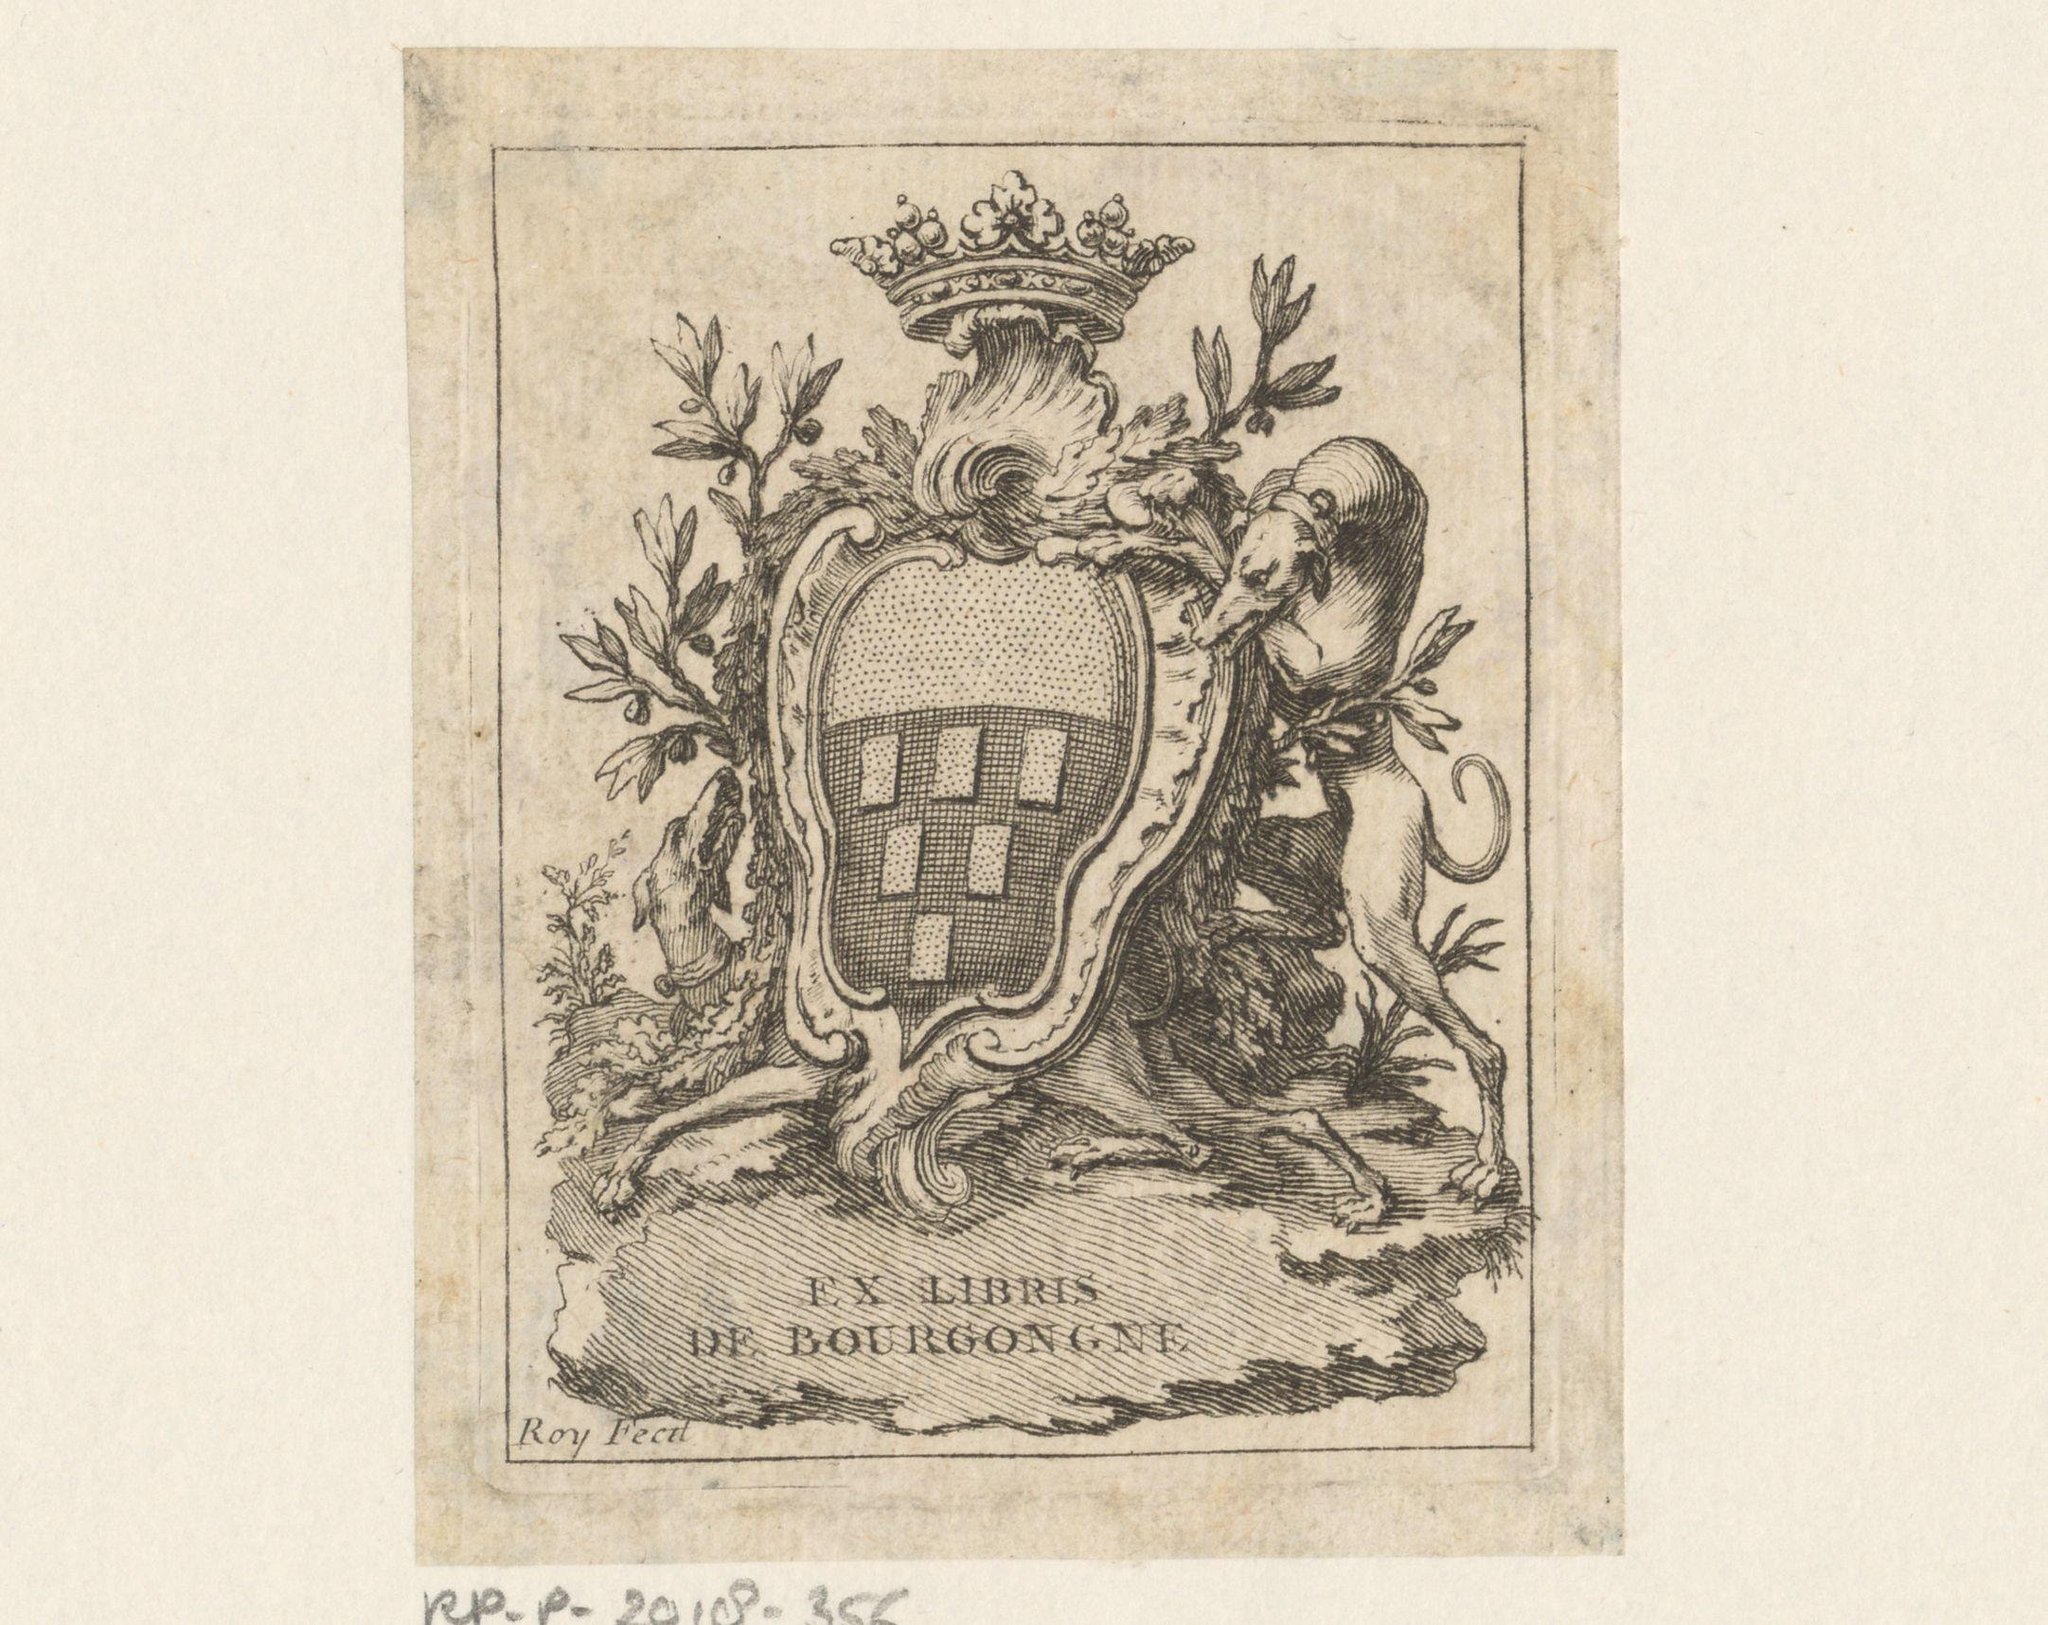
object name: bookplate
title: Ex libris van De Bourgongne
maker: Anonymous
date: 1700-1849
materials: paper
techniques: engraving, etching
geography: france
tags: armorial bearing, heraldry, dog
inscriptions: collector's mark: Lugt 2233, collector's mark: Lugt 2760